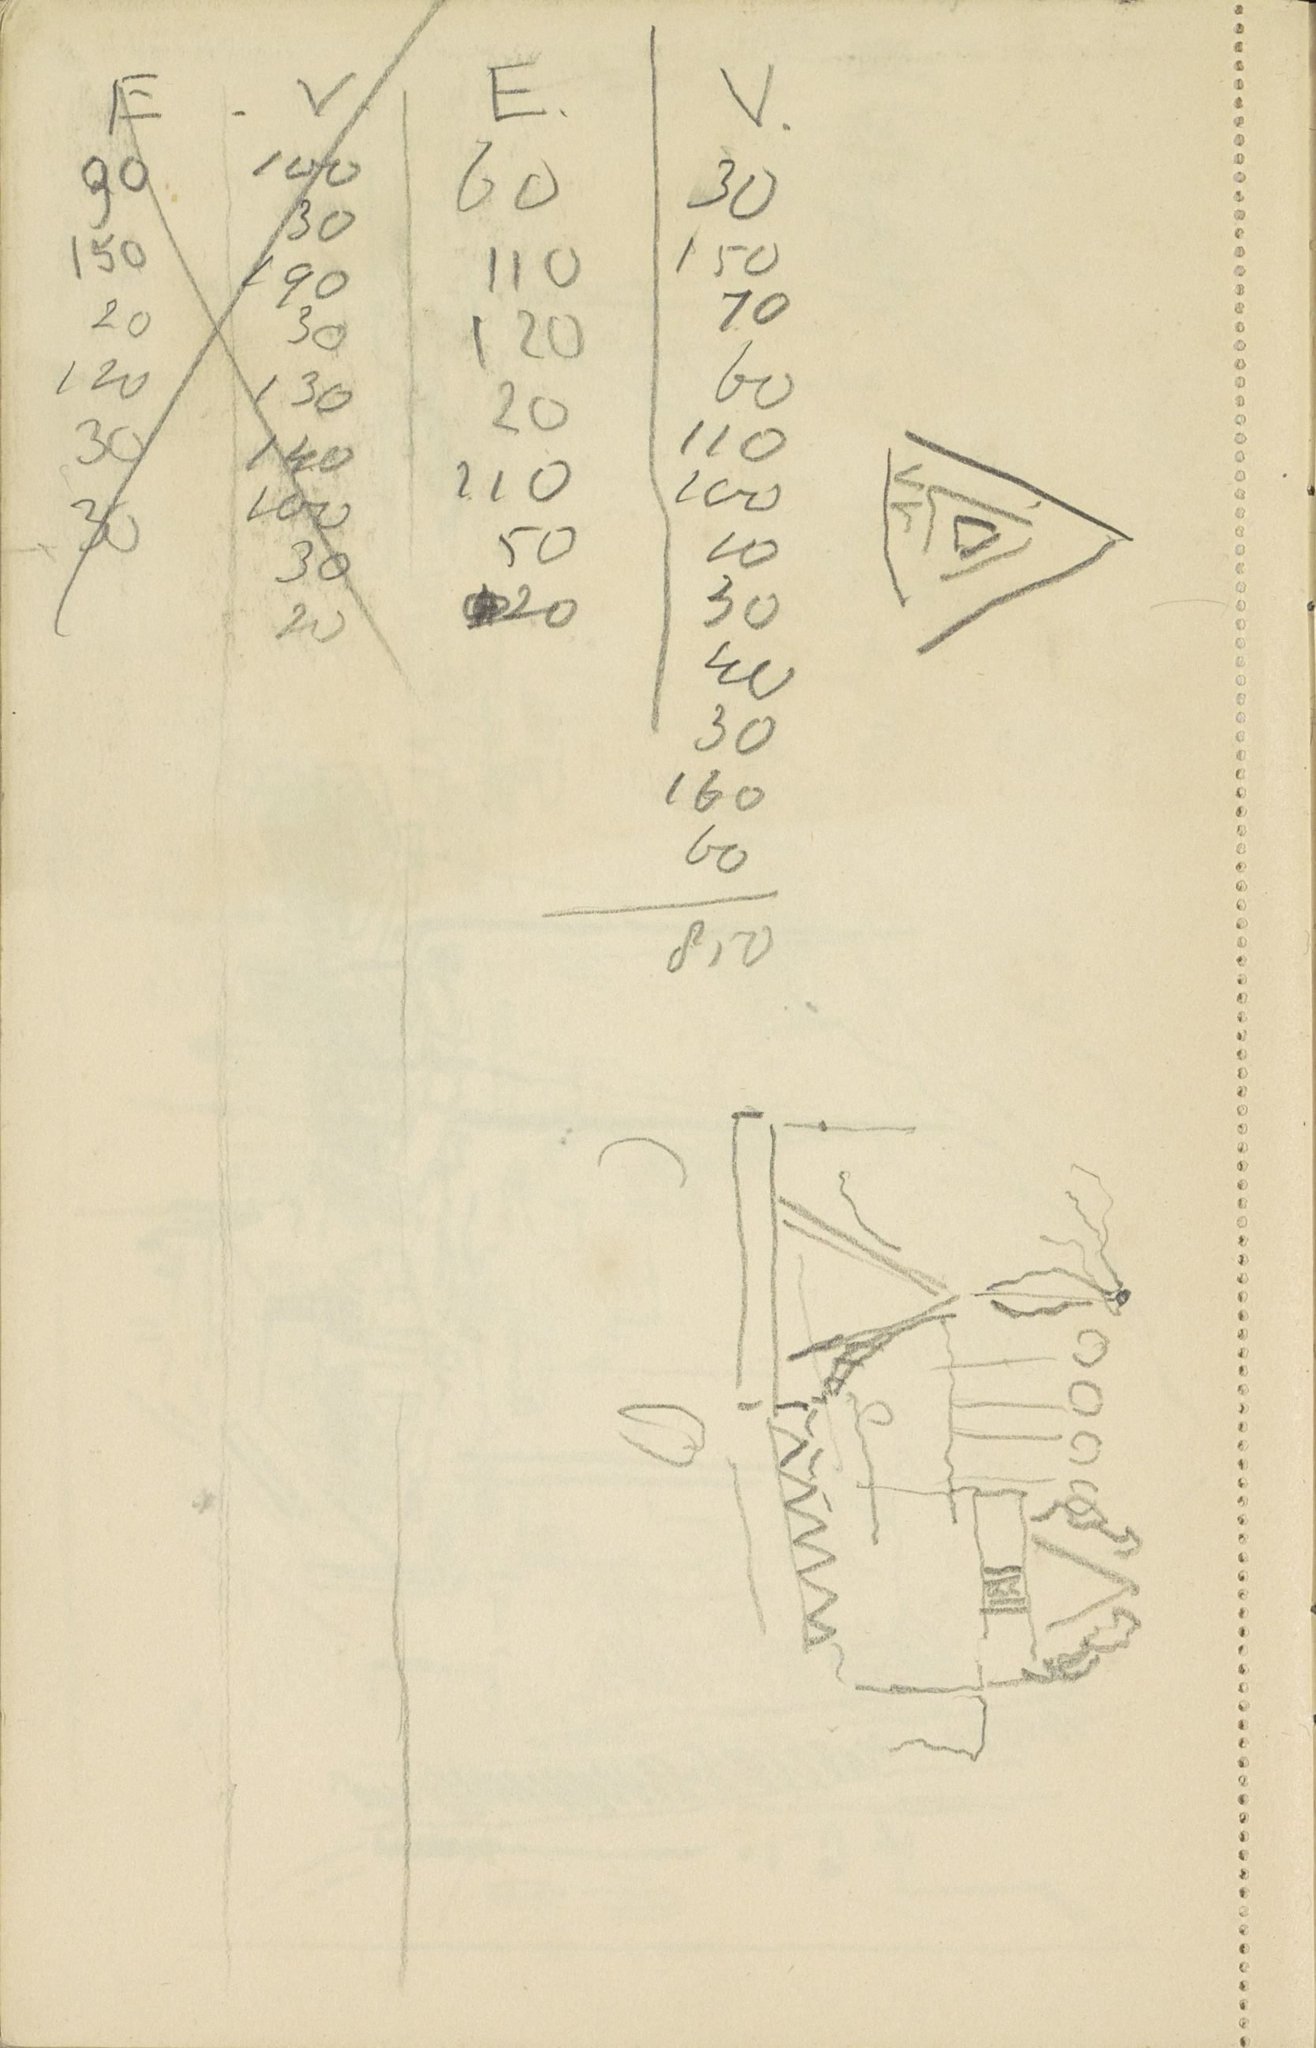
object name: sketchbook leaf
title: Studie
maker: cornelis vreedenburgh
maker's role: draughtsman, print maker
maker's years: 1880-1946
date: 1890-1946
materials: paper, pencil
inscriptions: annotation: ‘[...]’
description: Mogelijk een toren en een zeilboot. Blad 71 verso uit een schetsboek met 73 bladen.